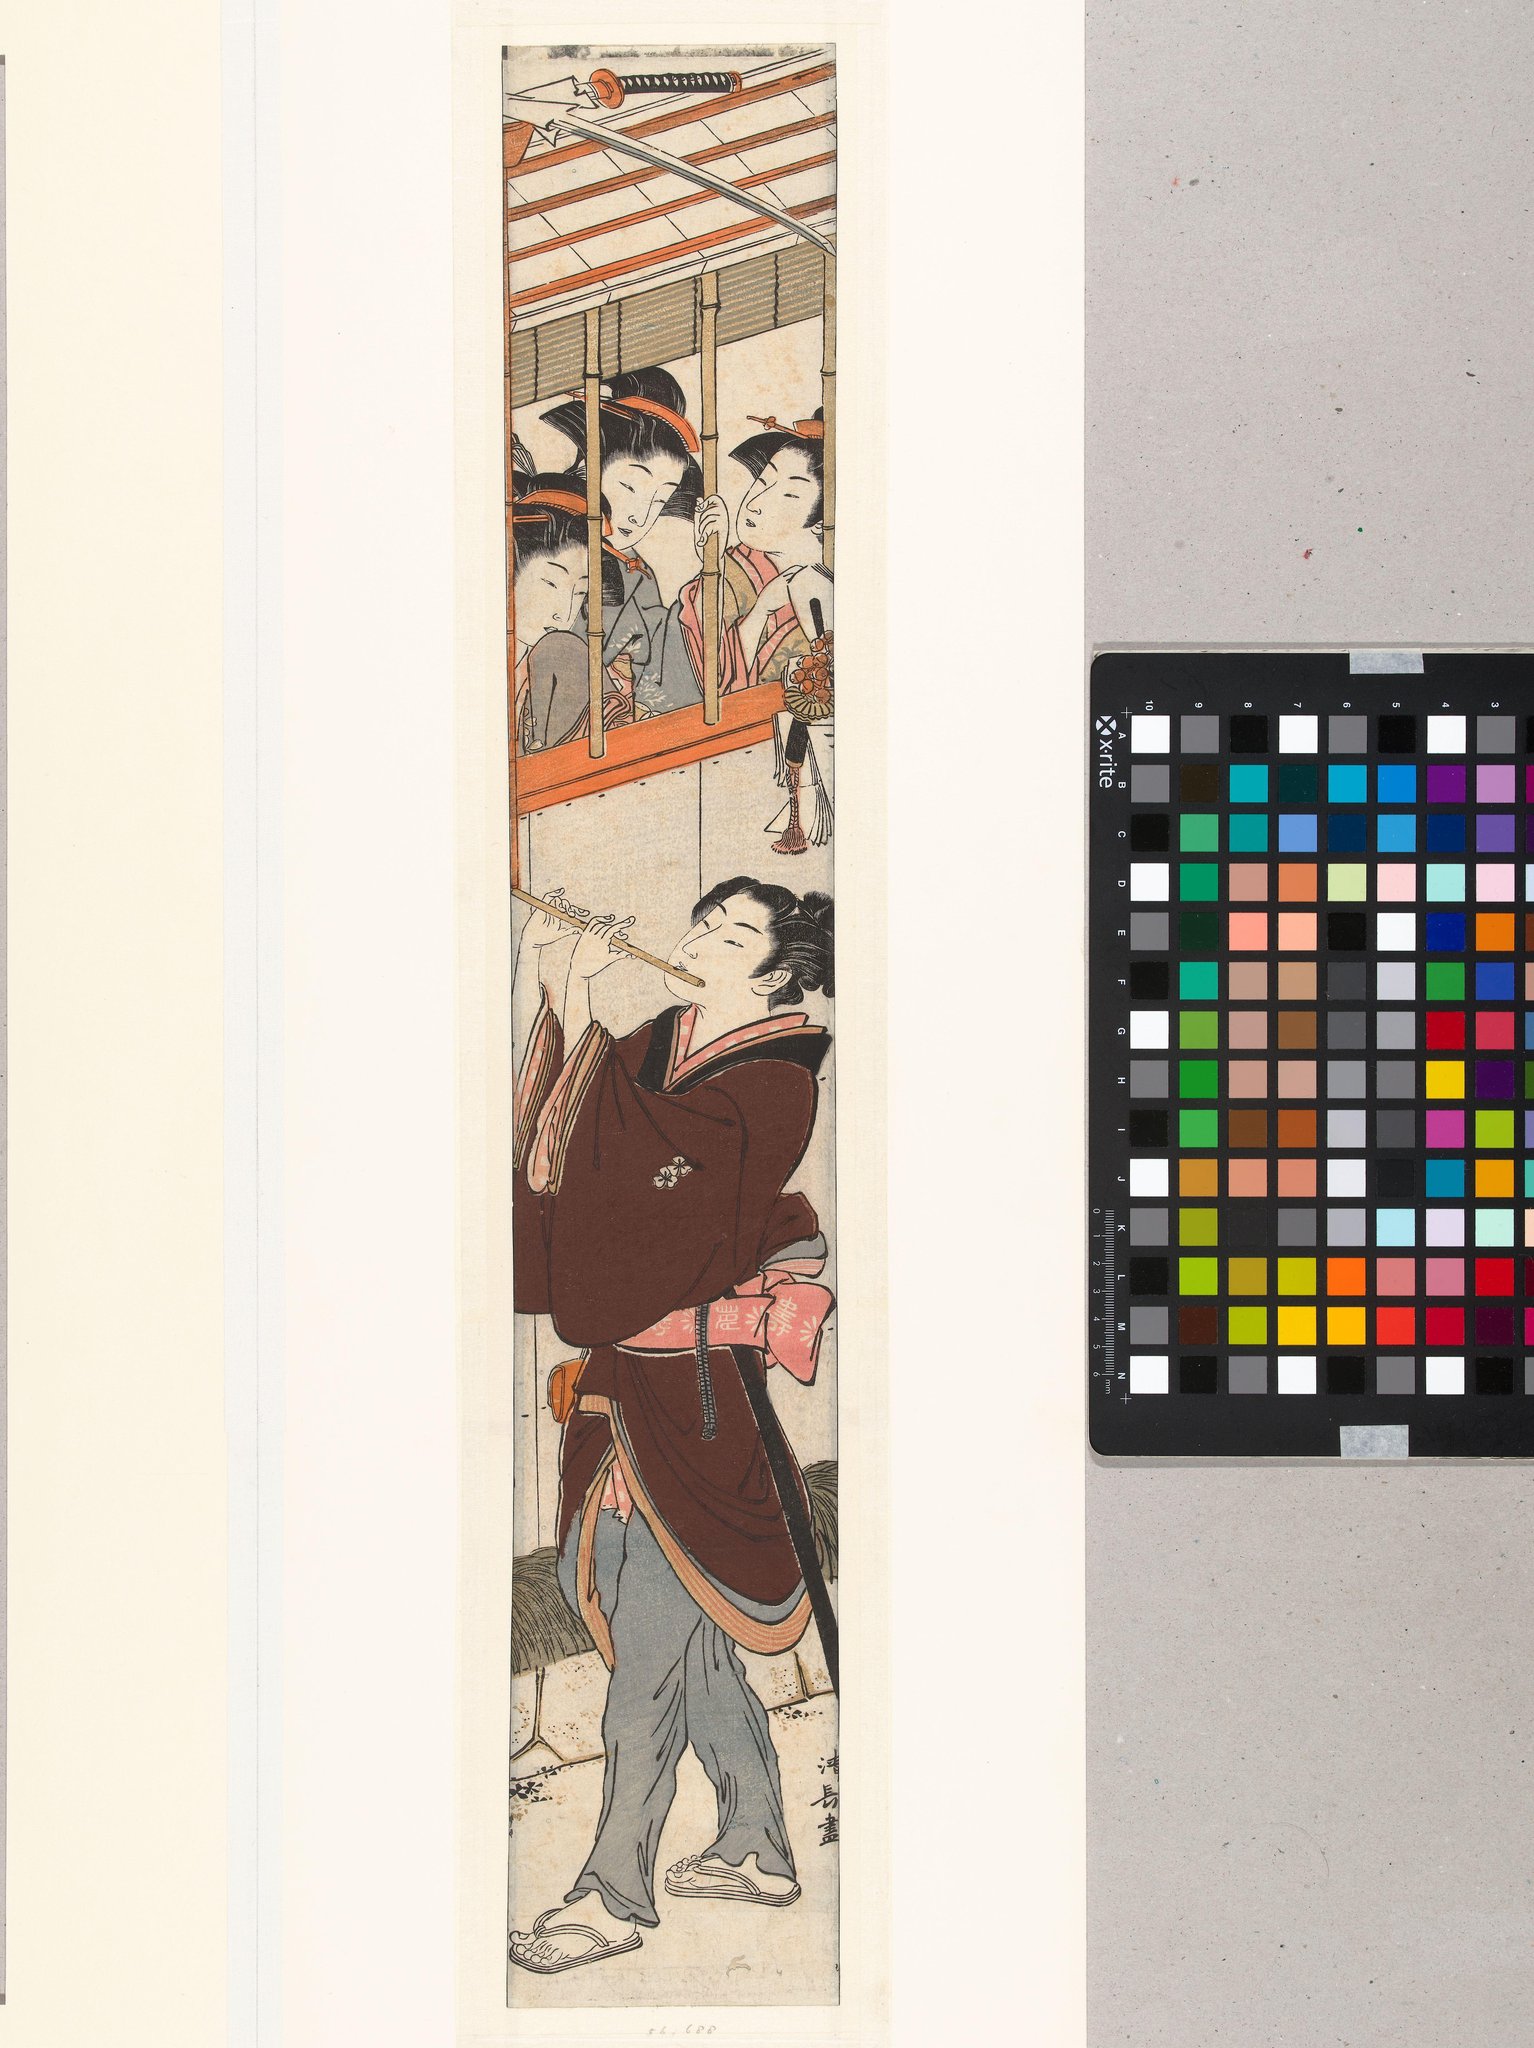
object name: print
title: Nieuwjaarsoptreden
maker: torii kiyonaga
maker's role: draughtsman, print maker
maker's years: 1752-1815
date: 1778-1782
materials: paper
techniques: woodcut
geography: japan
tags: one person playing wind instrument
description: Fluitspeler, met op het einde van zijn fluit een bamboe stok waarop twee zwaarden kruislings balanseren; drie vrouwen kijken toe vanachter een raam. Dit soort vermaak, daikagura, was populair tijdens Nieuwjaar.